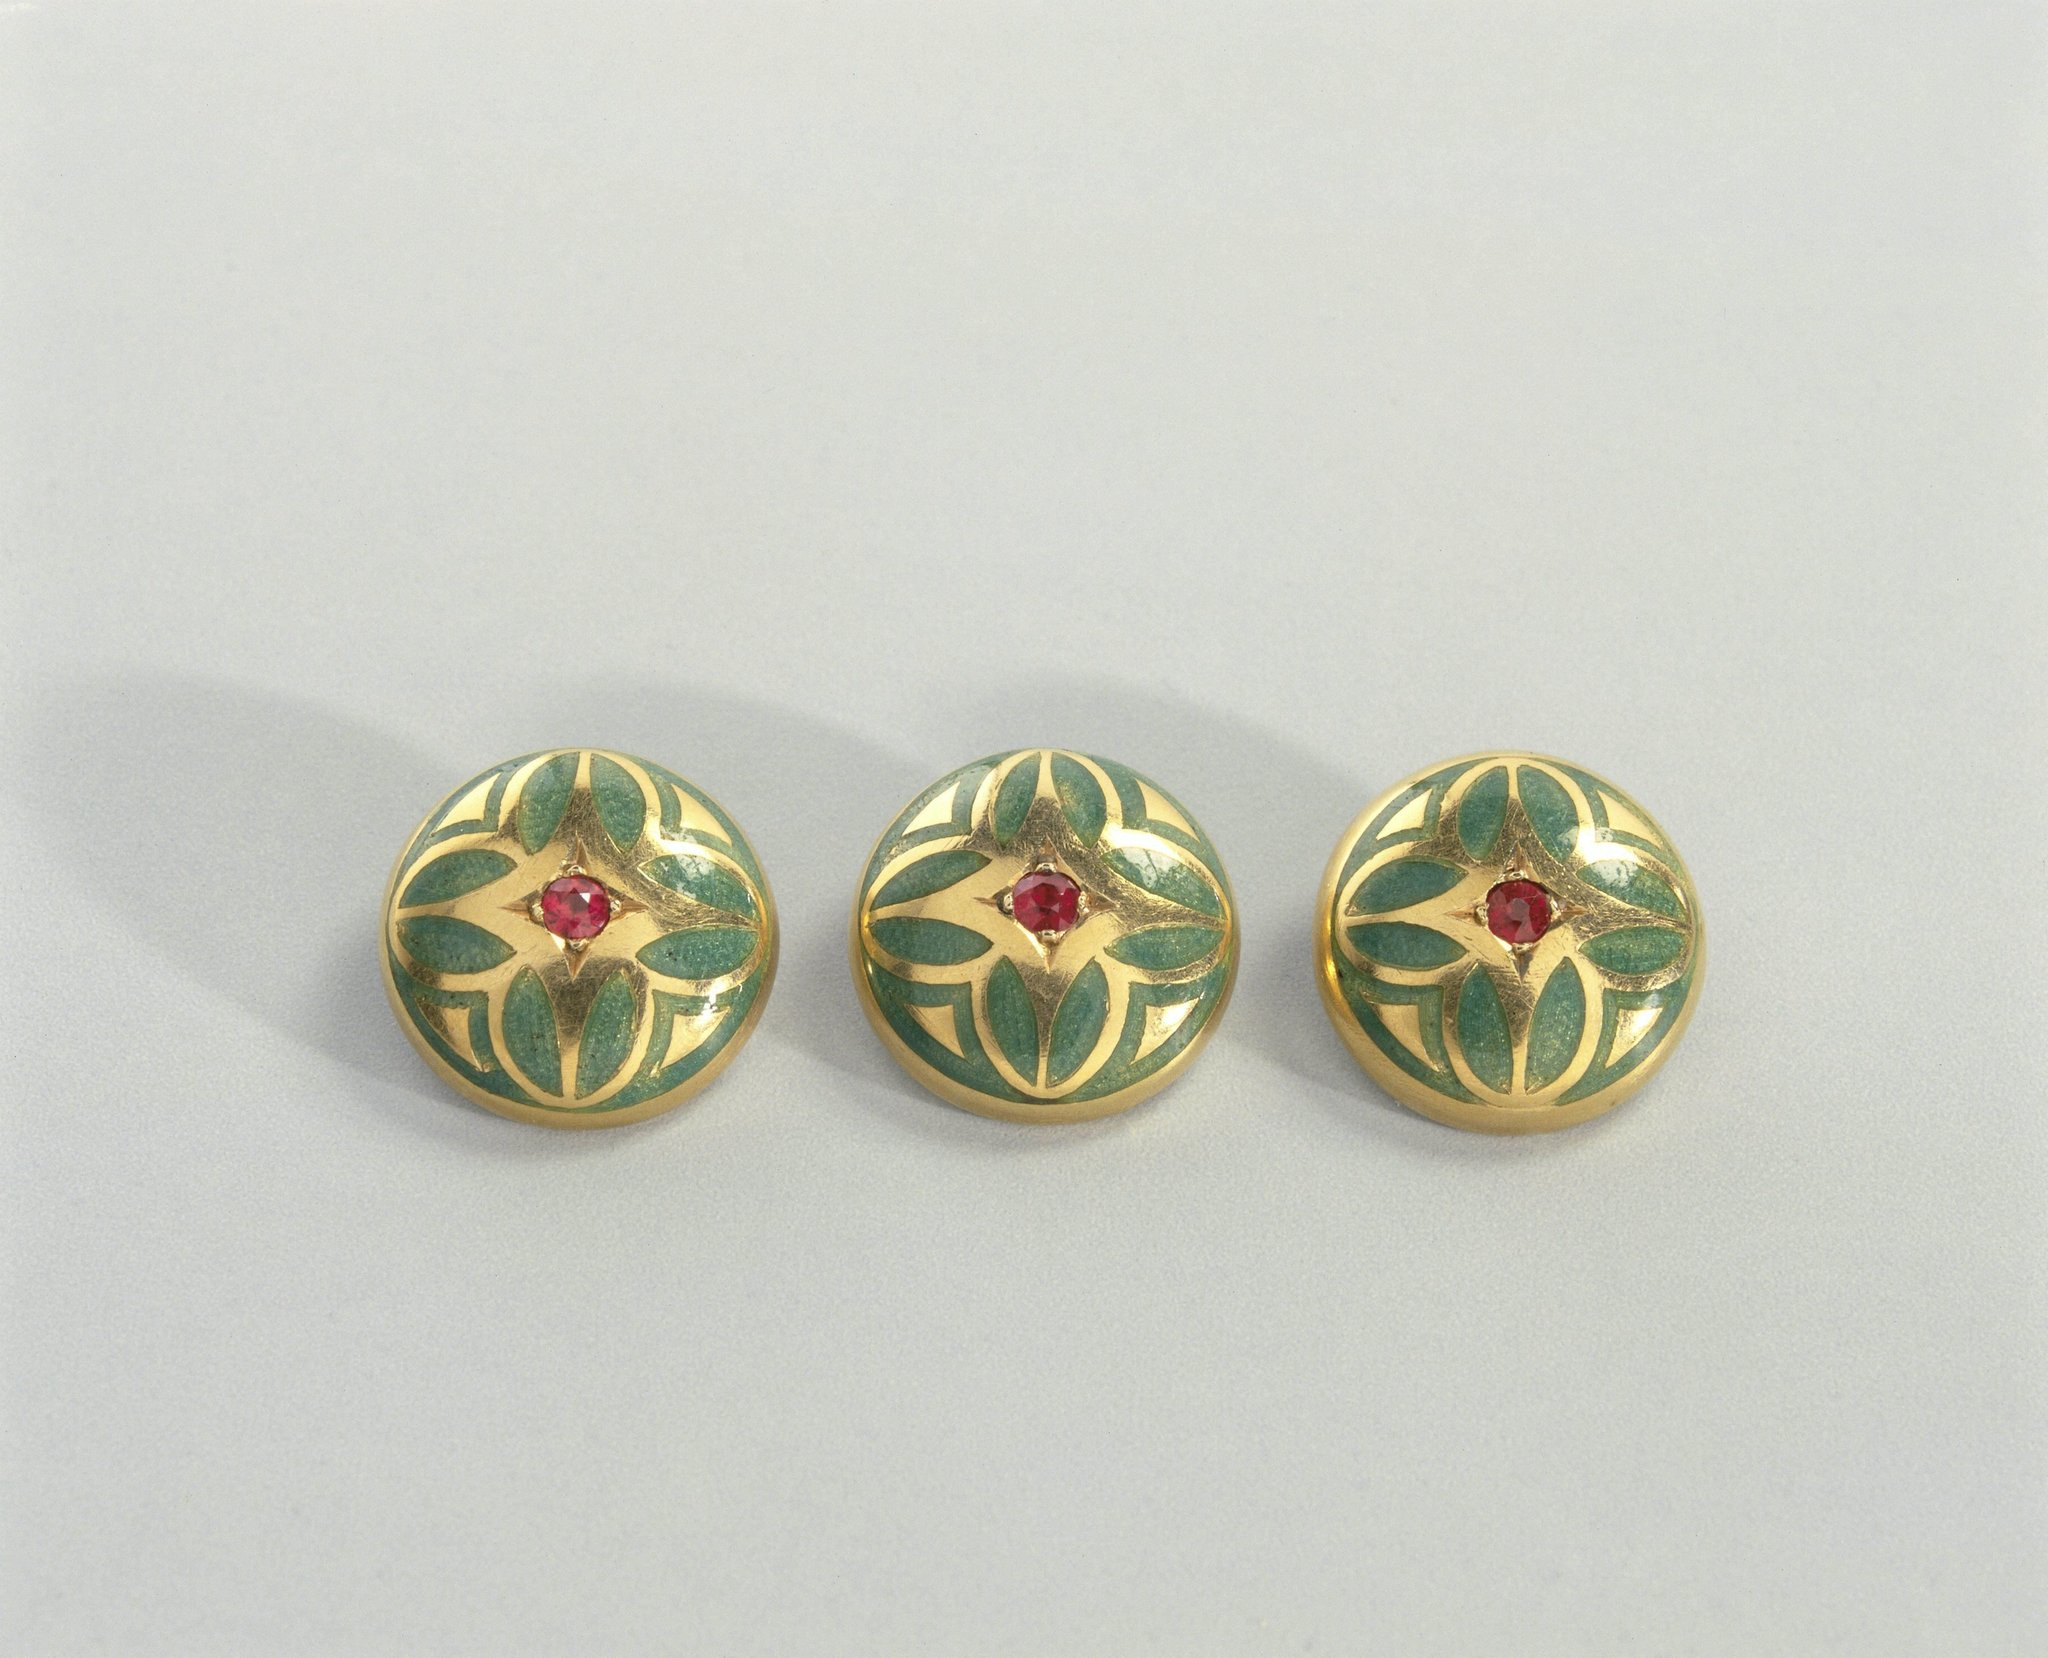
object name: button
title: Knoop van goud en lichtgroen email, met een robijn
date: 1908-1911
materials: gold, gemstone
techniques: enameling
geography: amsterdam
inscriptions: alloy mark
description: Jewellery. Gold, silver, enamel and semi-precious stones. Amsterdam, c. 1908 - 1911, by L.W. van Kooten, designed by Bert Nienhuis. Given by the Prins Bernhard Fonds, 1980.